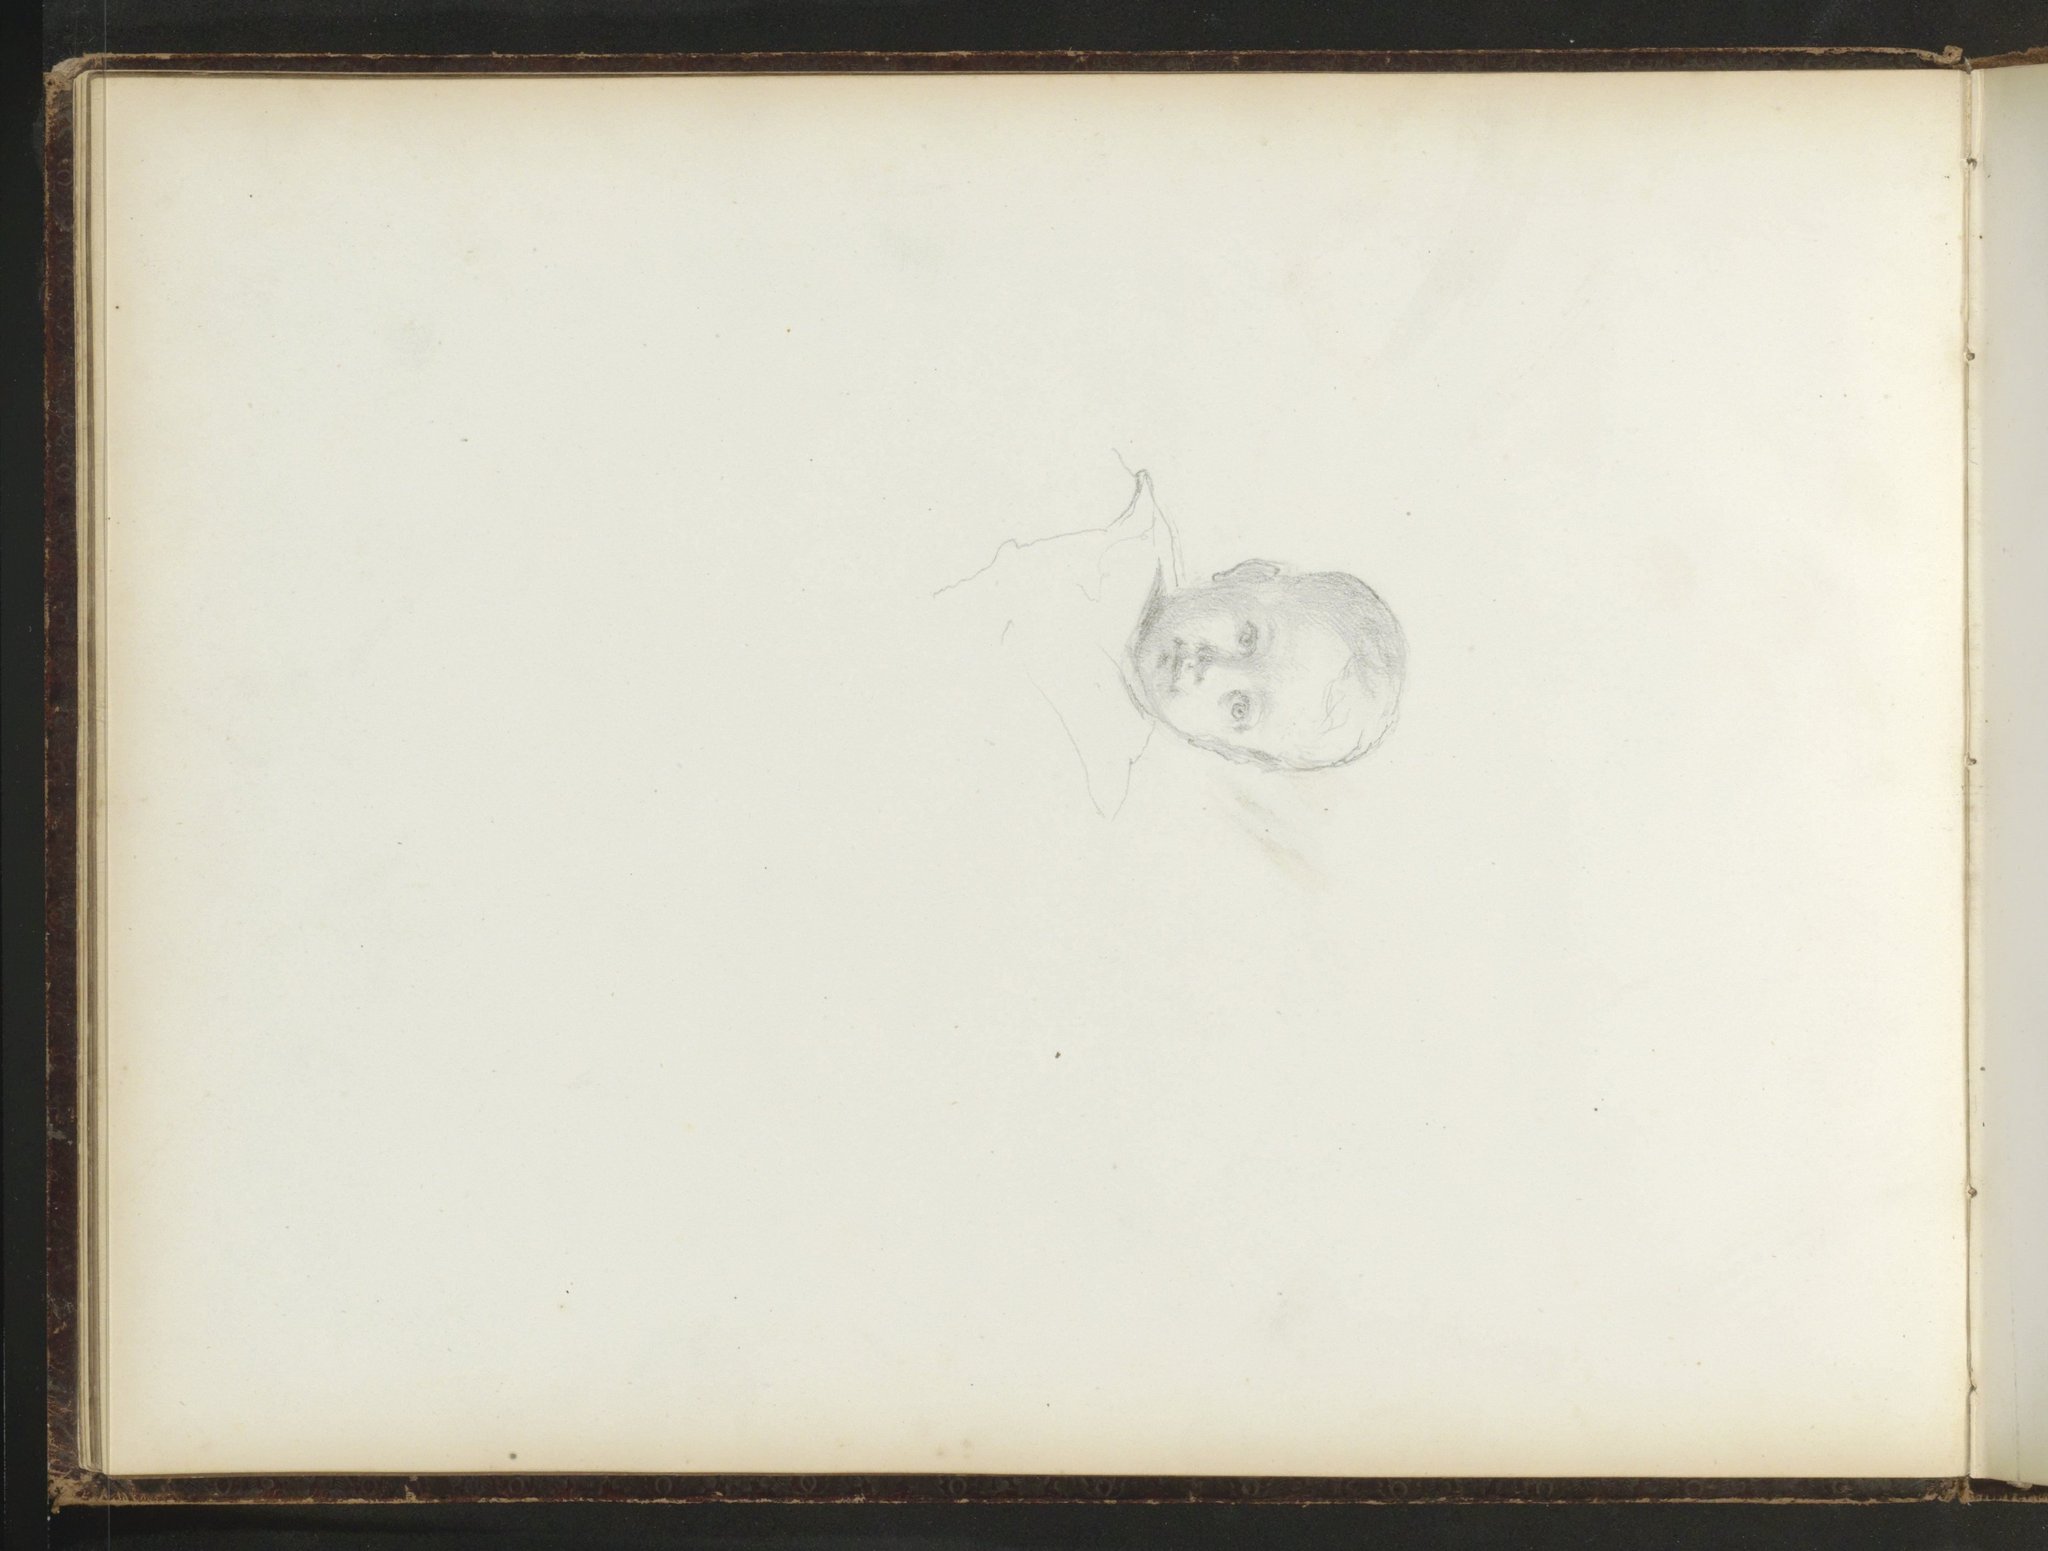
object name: sketchbook leaf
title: Kop van een jongen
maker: reinier craeyvanger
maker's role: draughtsman, print maker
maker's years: 1812-1880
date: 1822-1880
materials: paper, pencil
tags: head (human), toddler (male)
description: Blad 10 verso uit een schetsboek met 45 bladen.